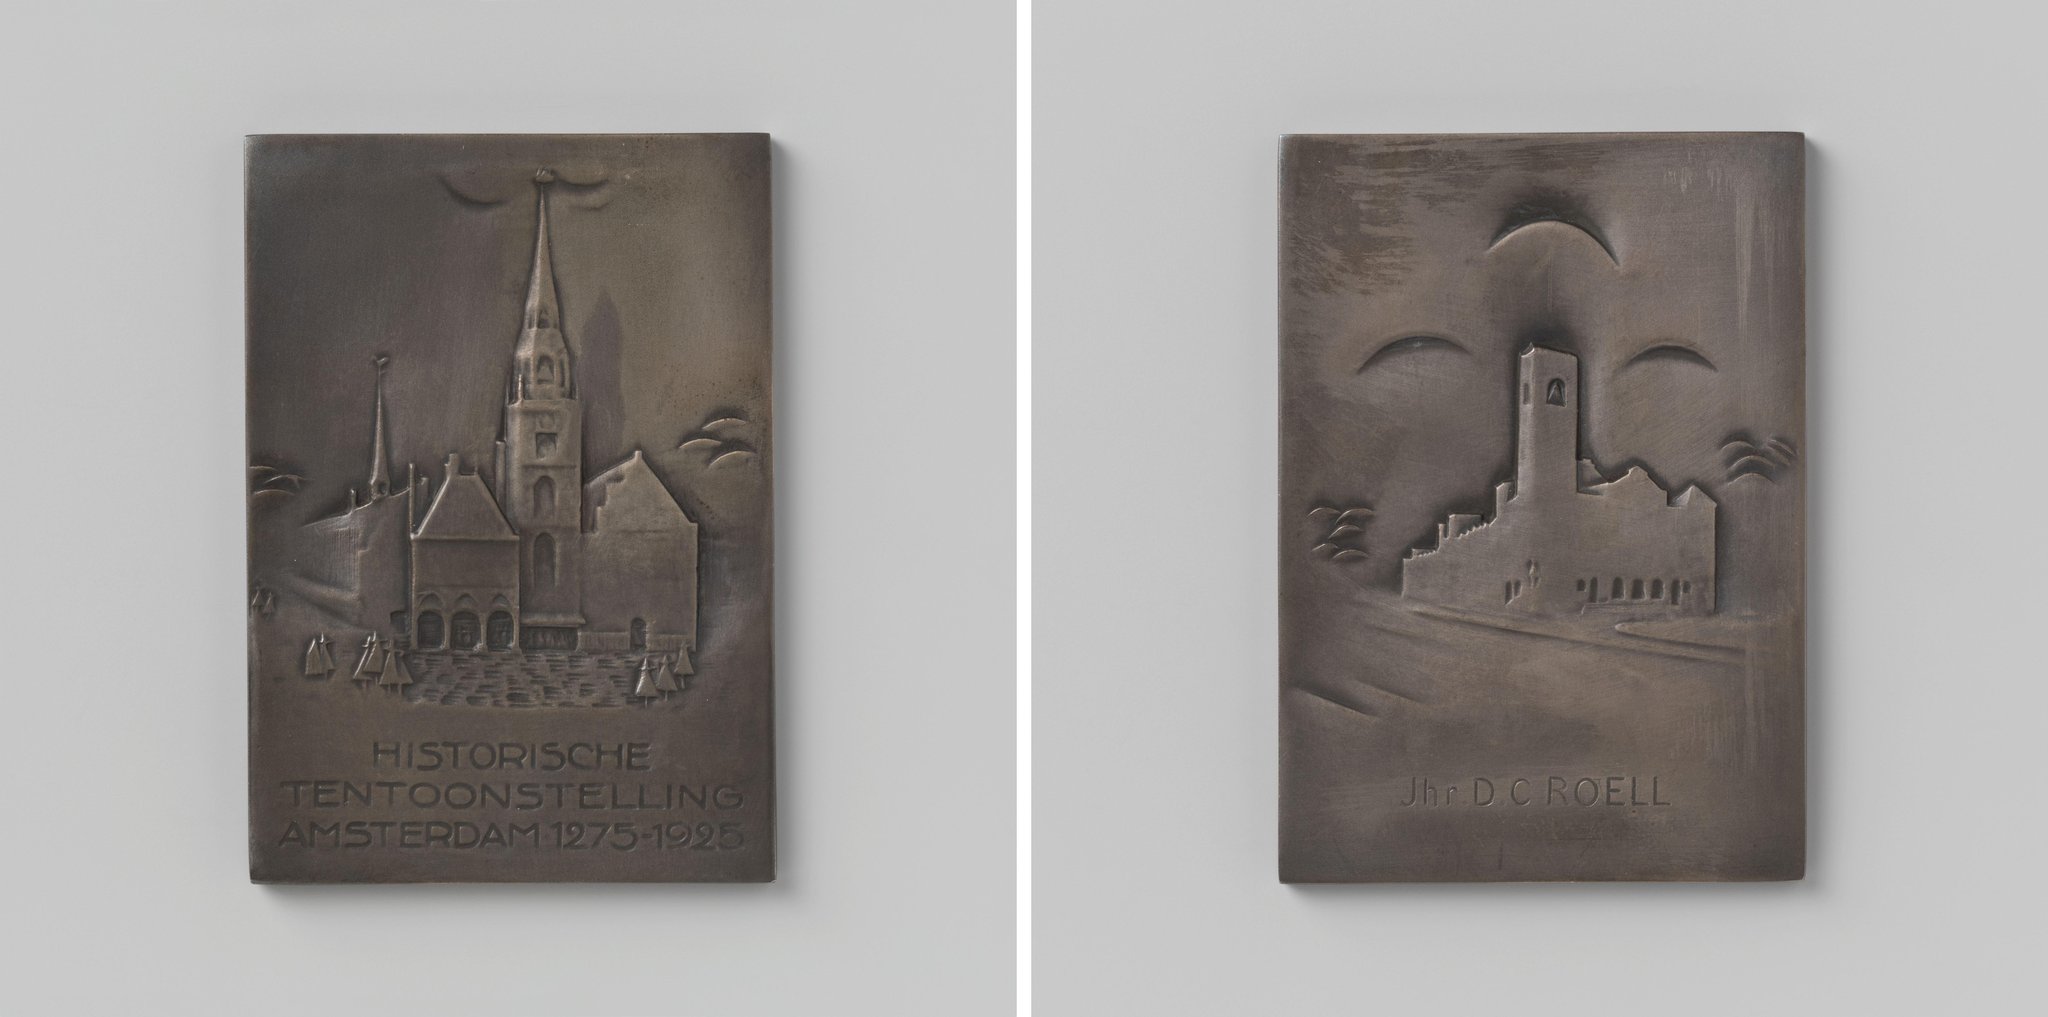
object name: plaque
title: Plaquette Historische Tentoonstelling Amsterdam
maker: bernard richters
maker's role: print maker, sculptor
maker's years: 1888-1966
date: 1925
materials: tin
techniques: casting, engraving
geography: voorschoten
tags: utrecht, amsterdam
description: Rechthoekige plaquette in doos. Voorzijde: Afbeelding oude stadhuis op de Dam, Amsterdam waaronder opschrift: HISTORISCHE TENTOONSTELLING AMSTERDAM 1275 - 1925. Keerzijde: Afbeelding Beurs van Berlage, Amsterdam waaronder opschrift: Jhr. D.C. ROELL. Oorspronkelijk in blauw etui.